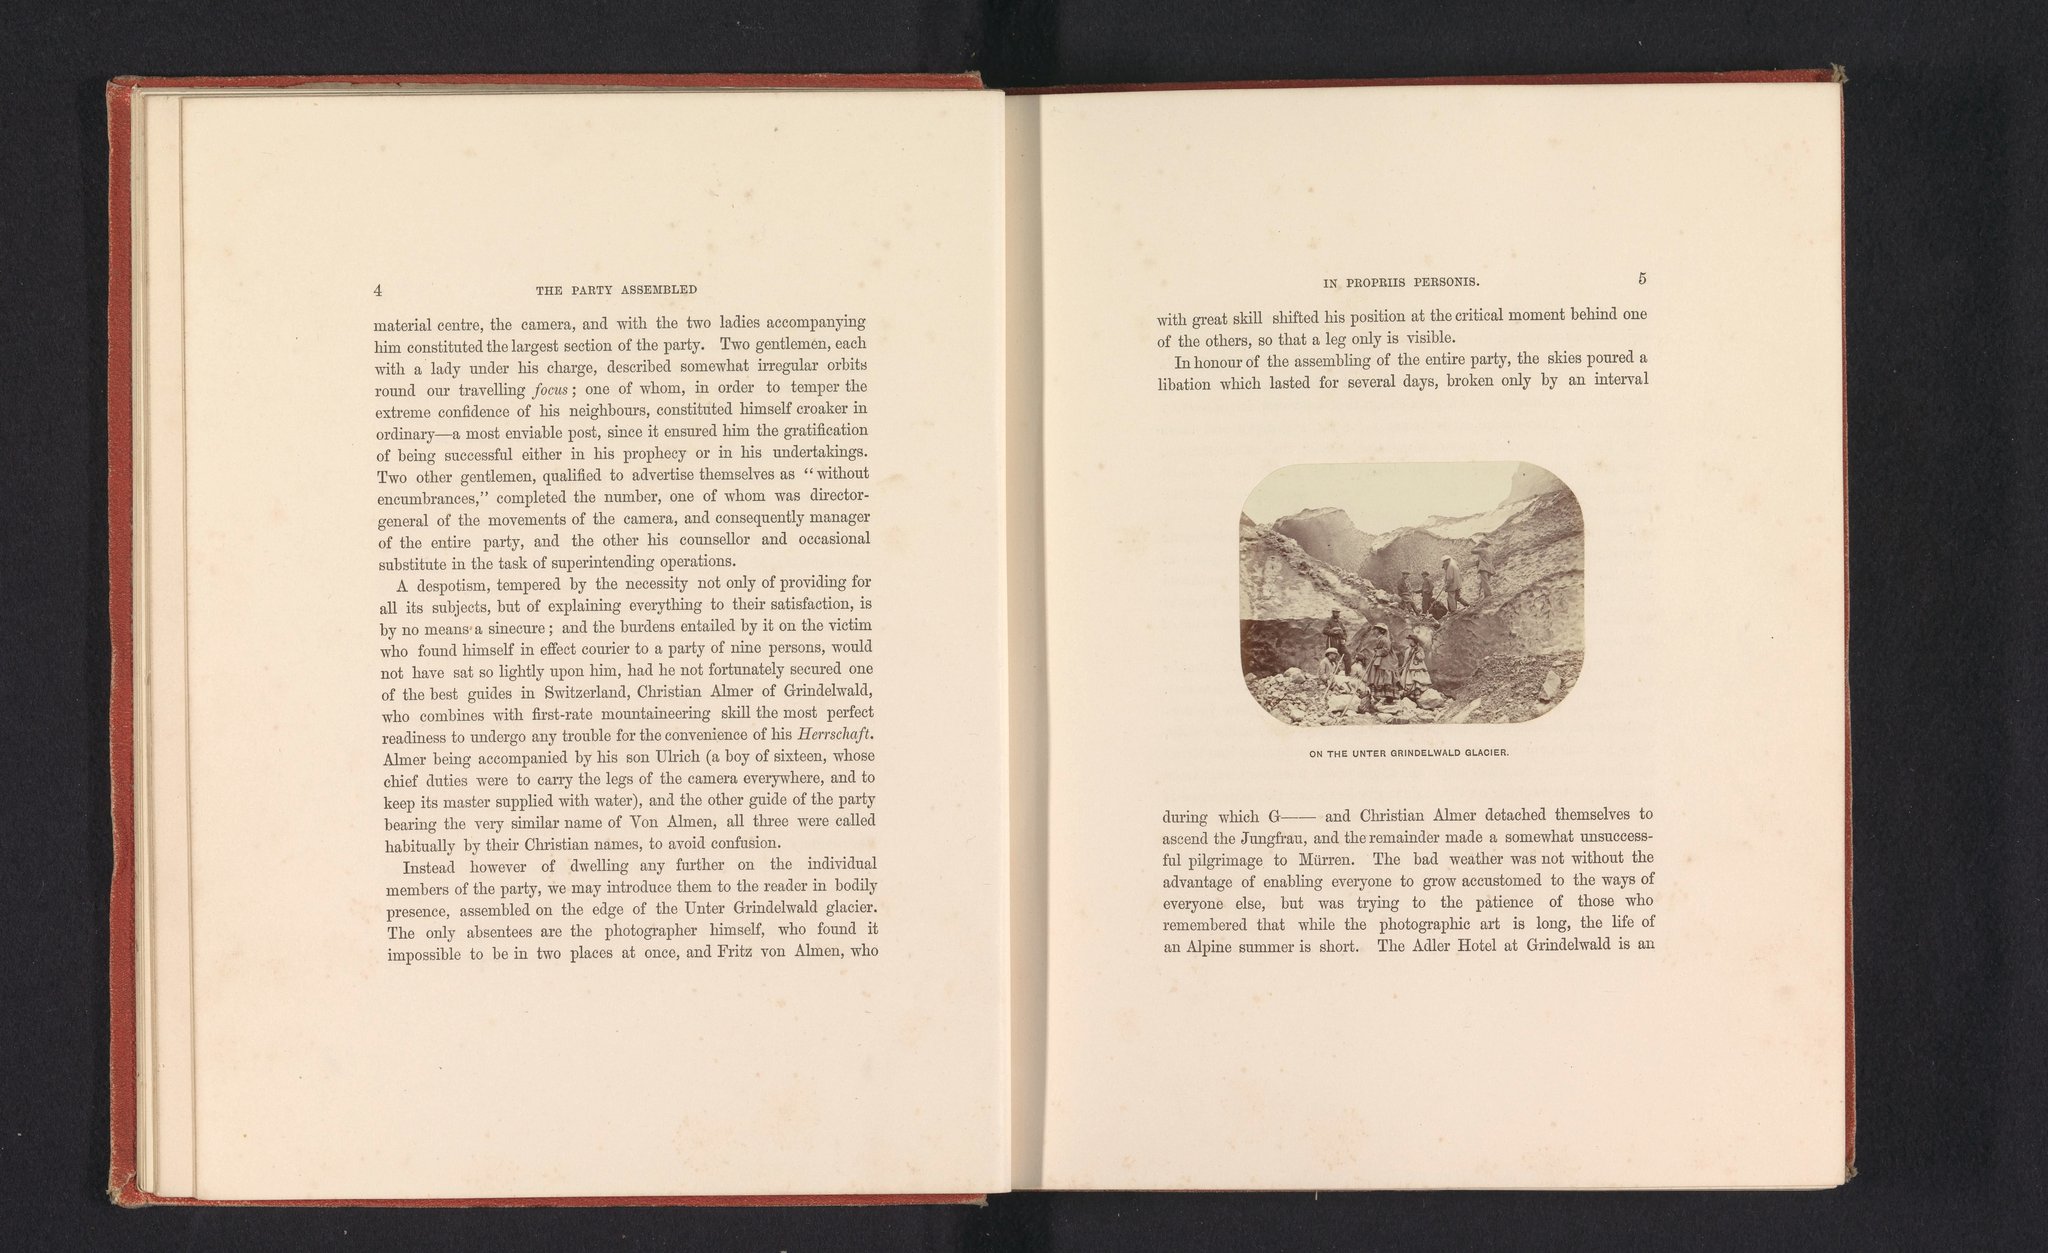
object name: page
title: On the Unter Grindewald glacier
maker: ernest edwards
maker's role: fotograaf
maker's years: 1837-1903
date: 1850-1866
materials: photographic support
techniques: albumen print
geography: unterer grindelwaldgletsjer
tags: glacier, exploration, expedition, voyage of discovery